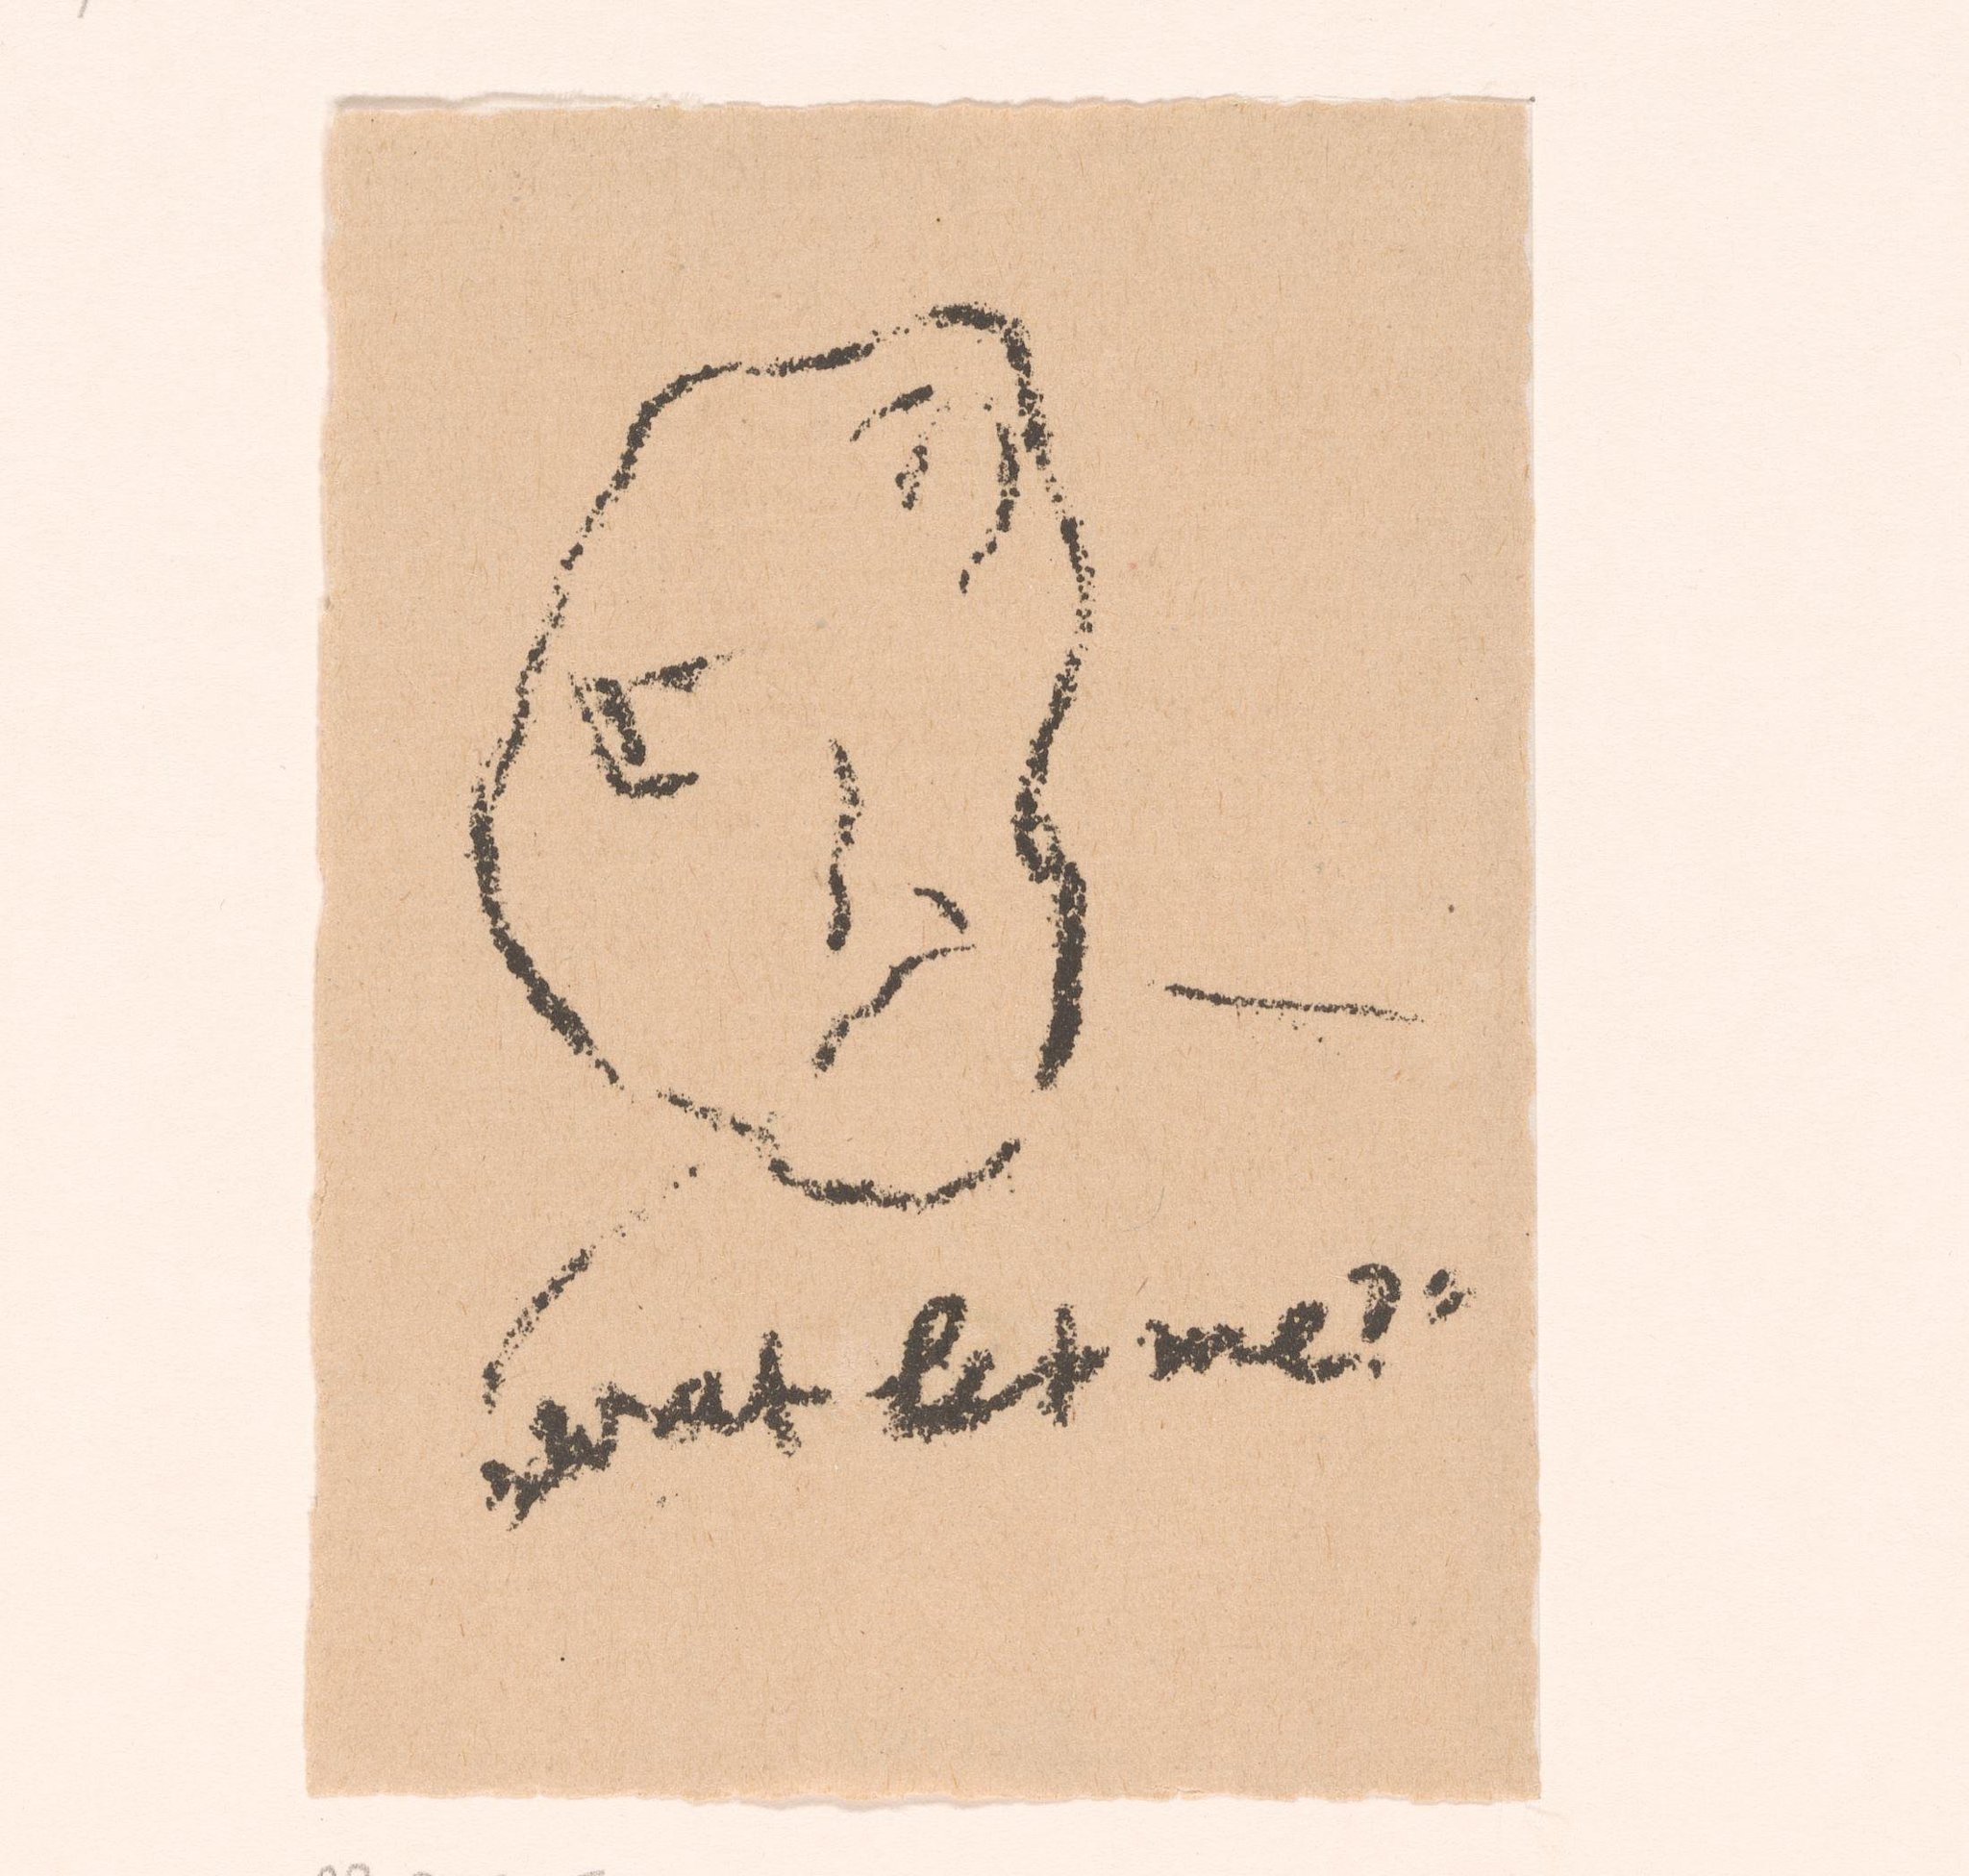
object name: print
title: Wat let me?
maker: erich wichmann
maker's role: print maker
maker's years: 1890-1929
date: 1923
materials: paper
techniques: lithograph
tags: caricatures (human types)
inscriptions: collector's mark: Lugt 2228